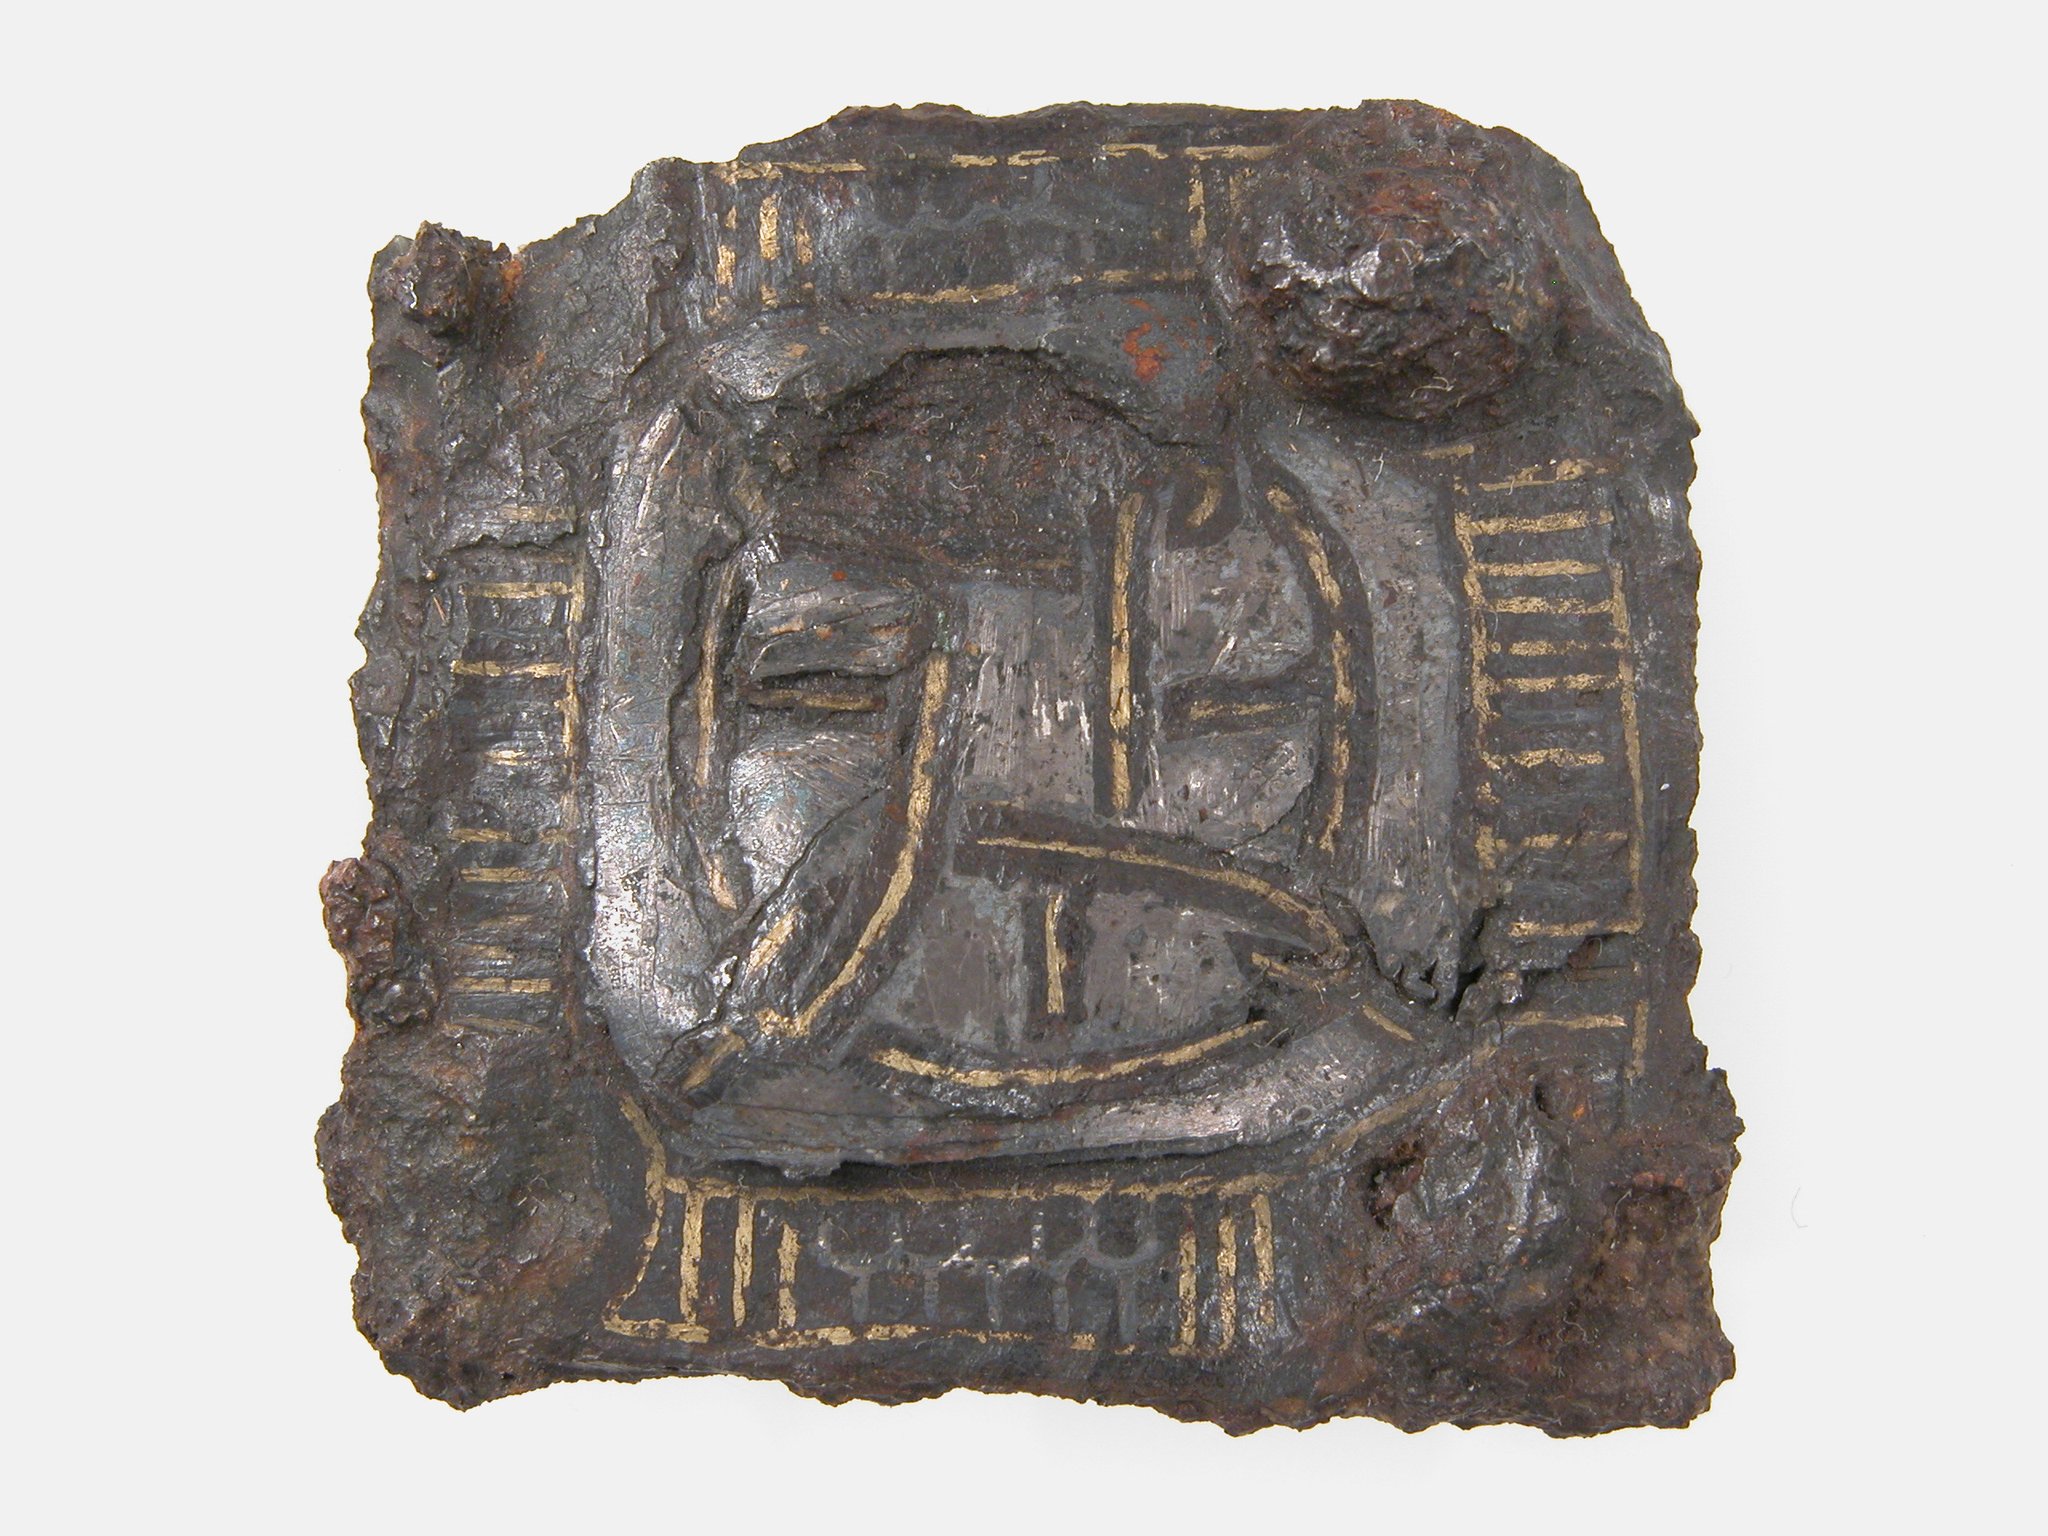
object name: belt plate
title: Backplate of a Belt Buckle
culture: frankish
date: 501-700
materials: brass, iron, silver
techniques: inlay